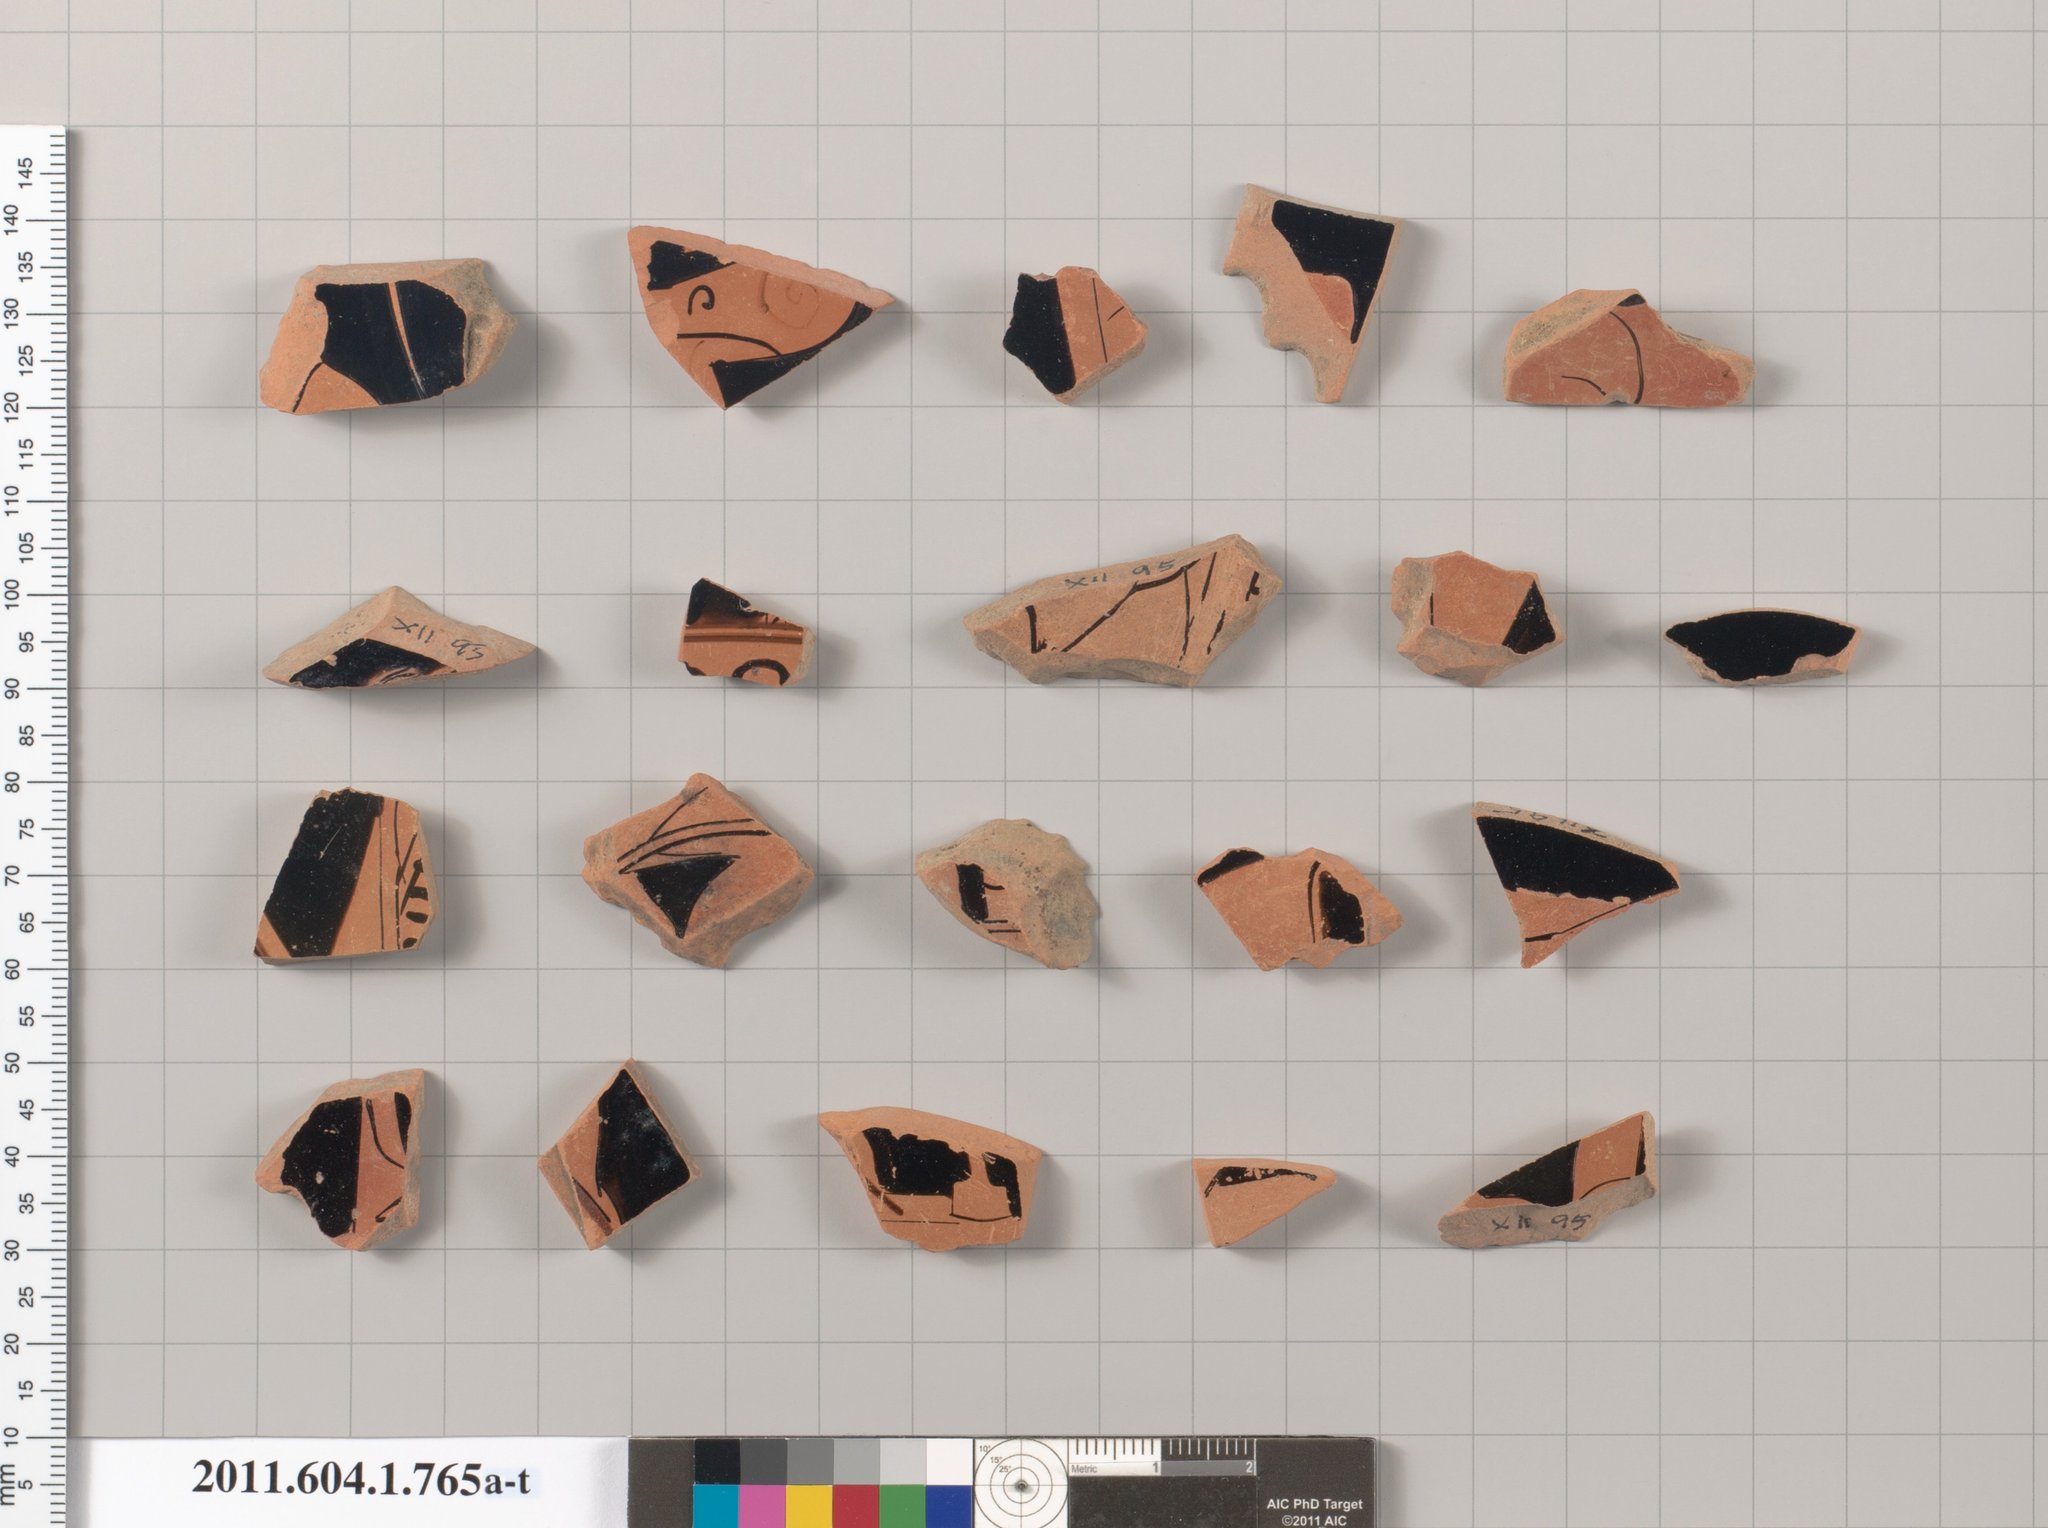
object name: kylix fragment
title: Terracotta fragments of kylikes (drinking cups)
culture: greek, attic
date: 500-401 BCE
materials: terracotta